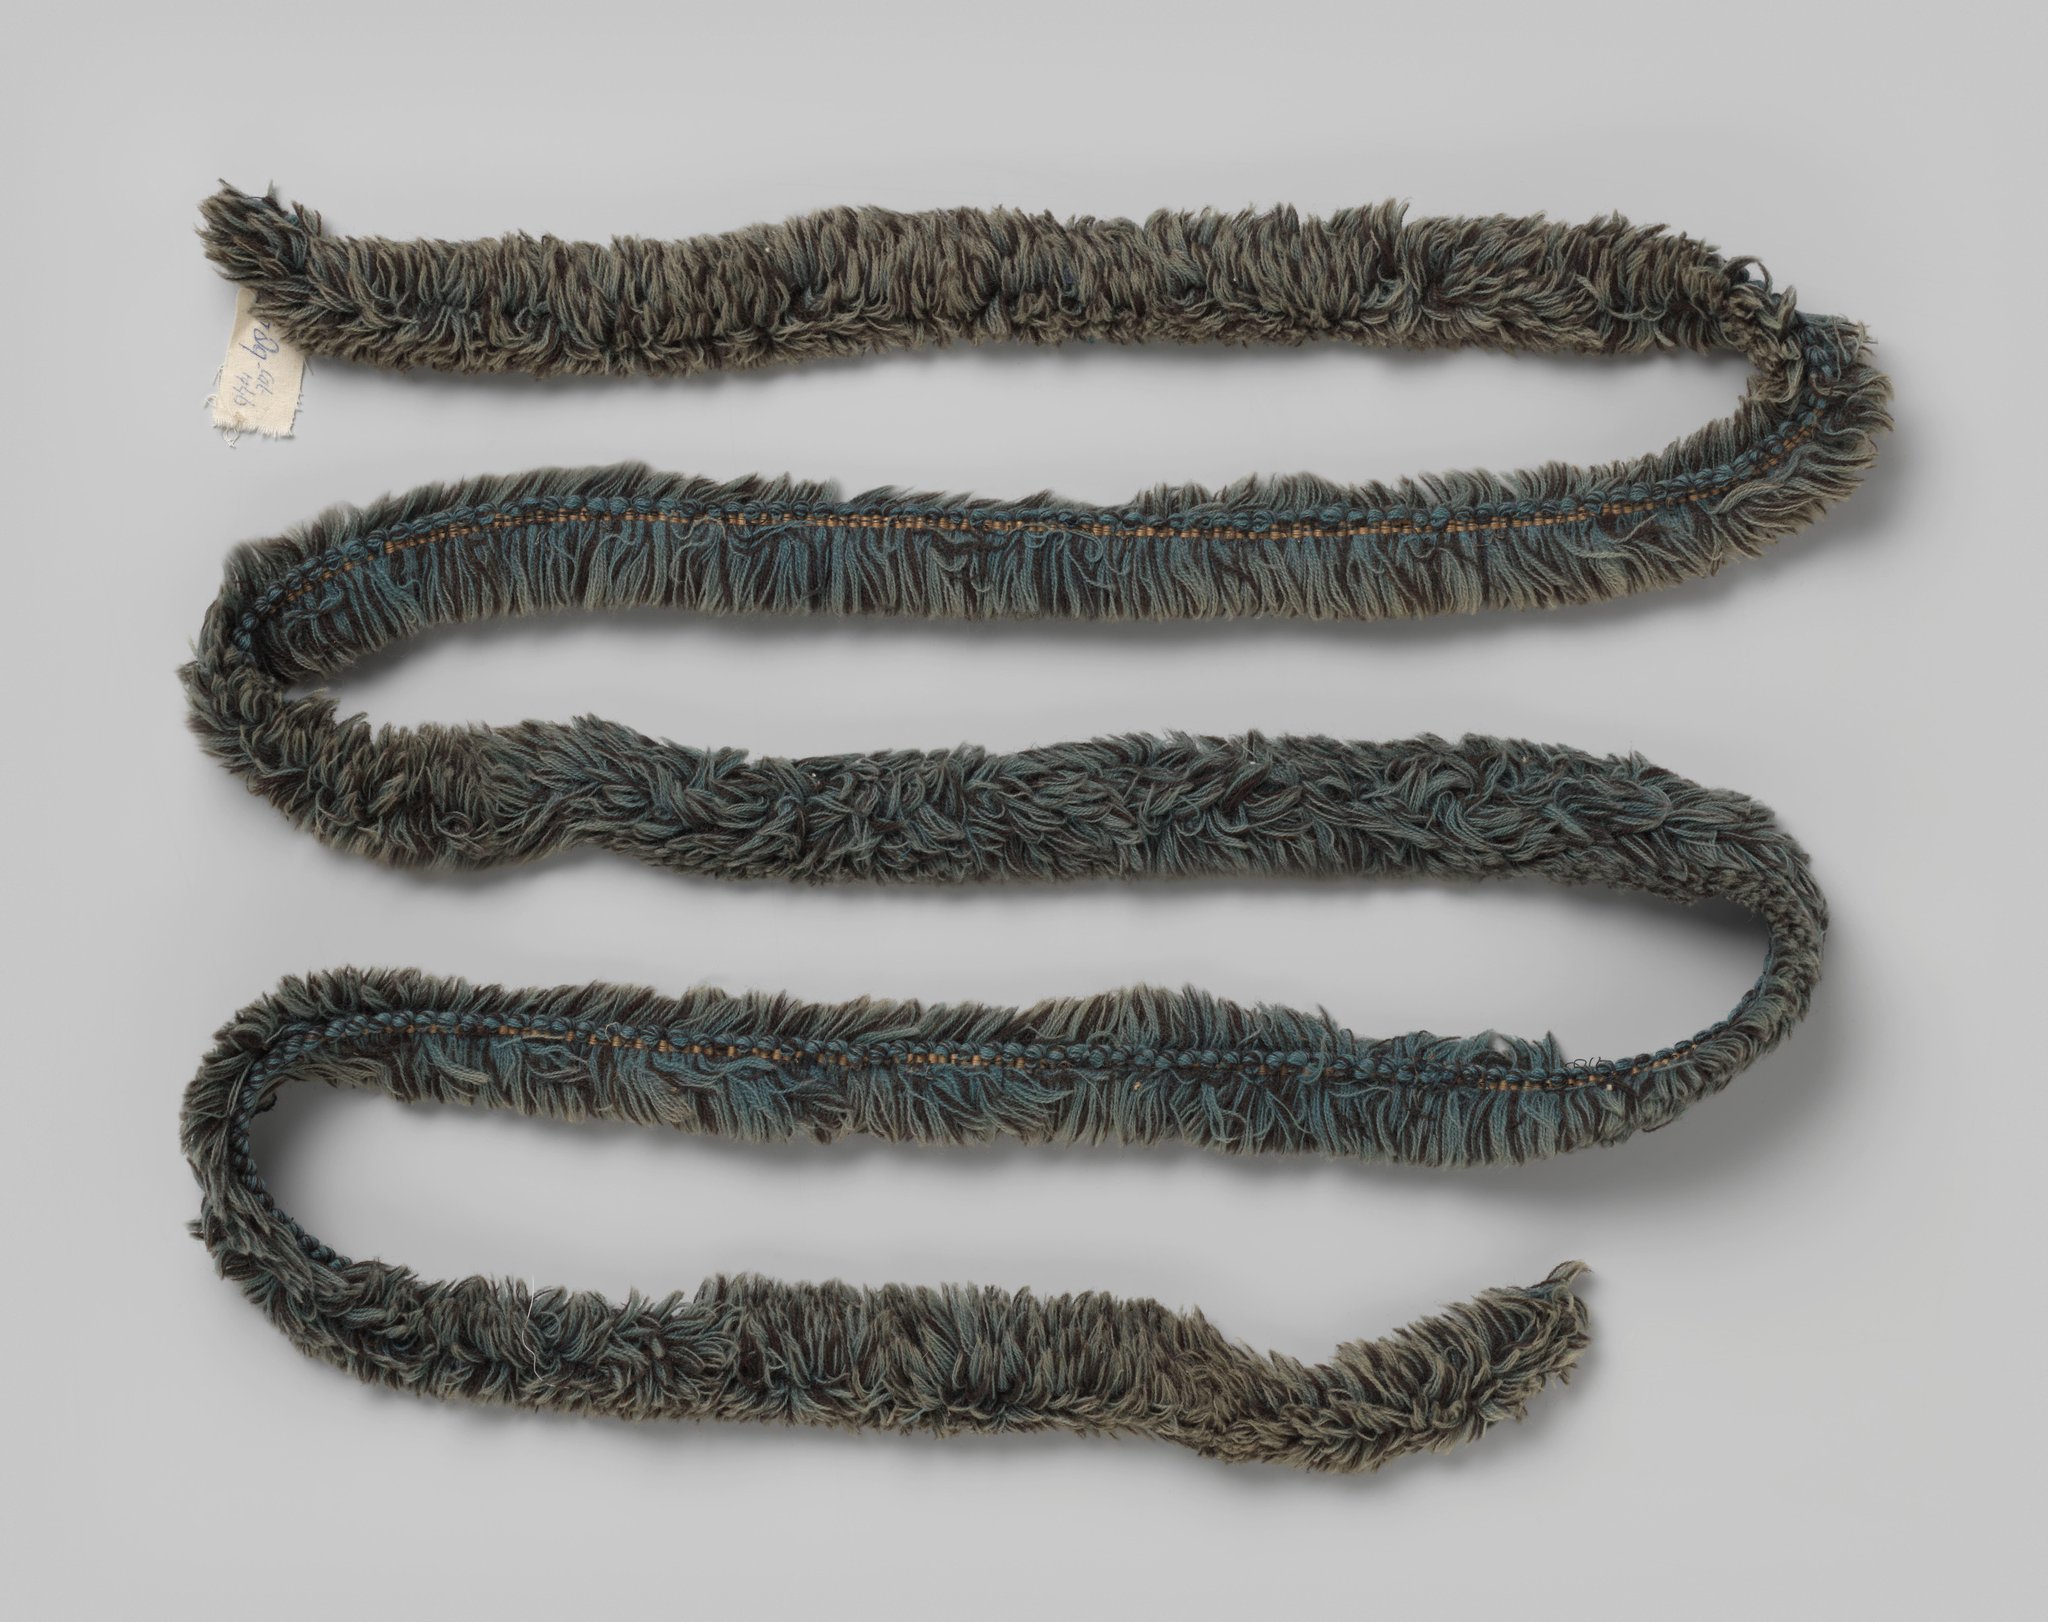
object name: fringe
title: Franje van een kussenovertrek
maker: Anonymous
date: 1680-1700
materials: wool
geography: northern netherlands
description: Franje van een magistratenkussen met het gekroonde Hollandse wapen met de klimmende leeuw in de Hollandse tuin voorgesteld.